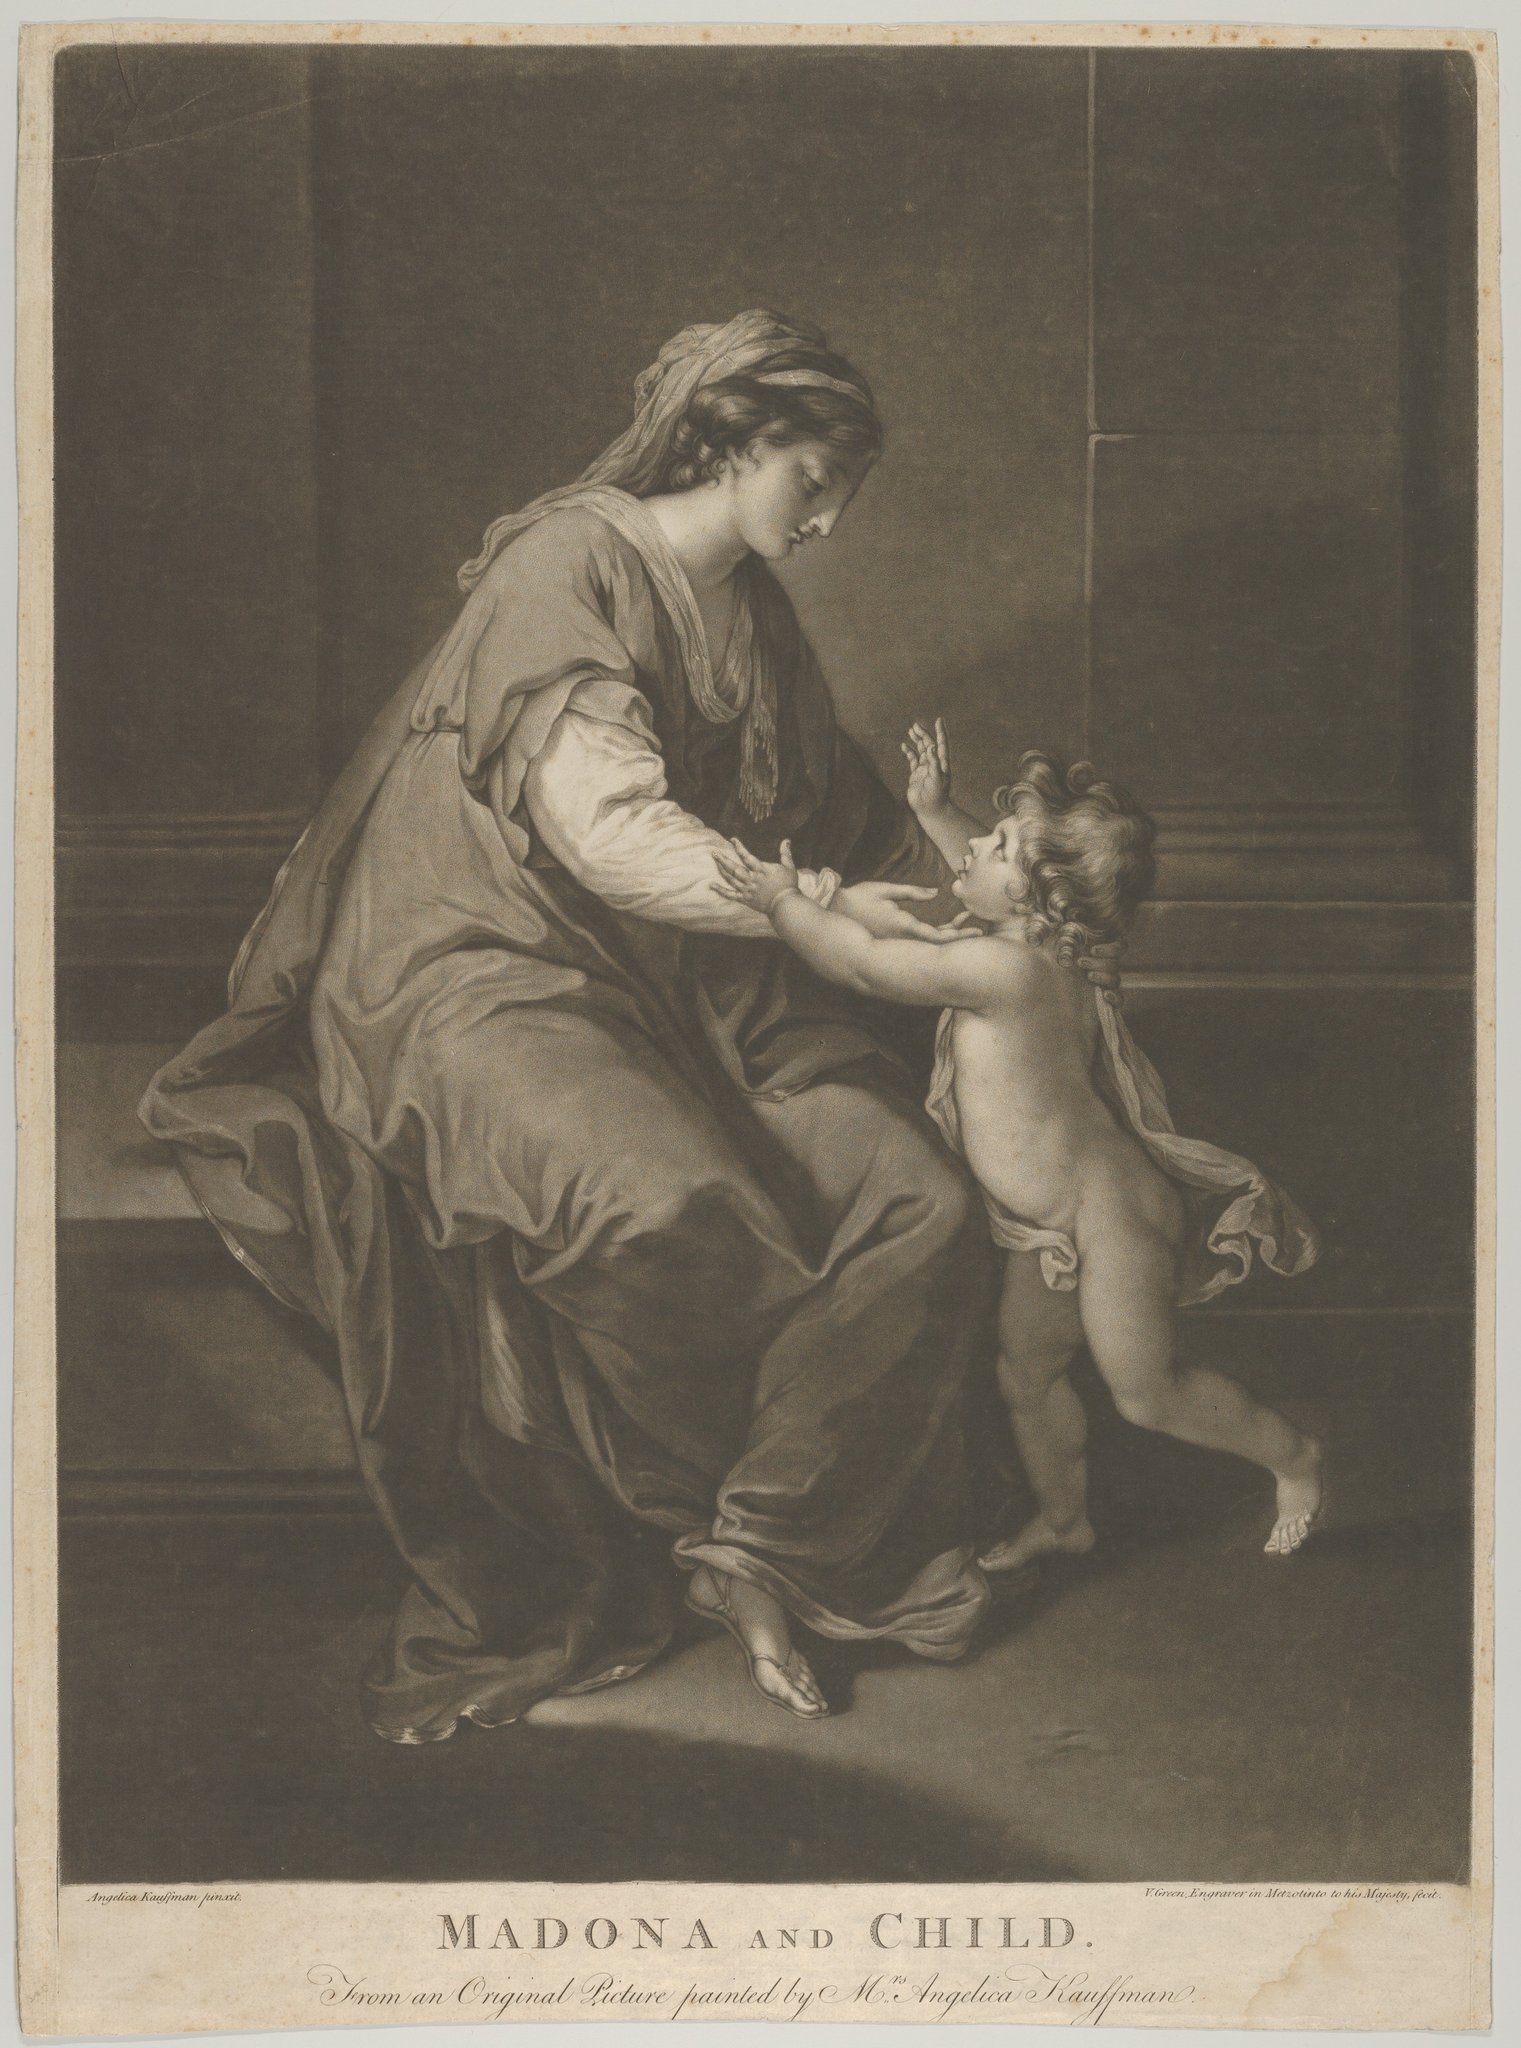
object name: print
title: Madonna and Child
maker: valentine green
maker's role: engraver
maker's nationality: british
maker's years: 1739-1813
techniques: mezzotint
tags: madonna and child,virgin mary,jesus